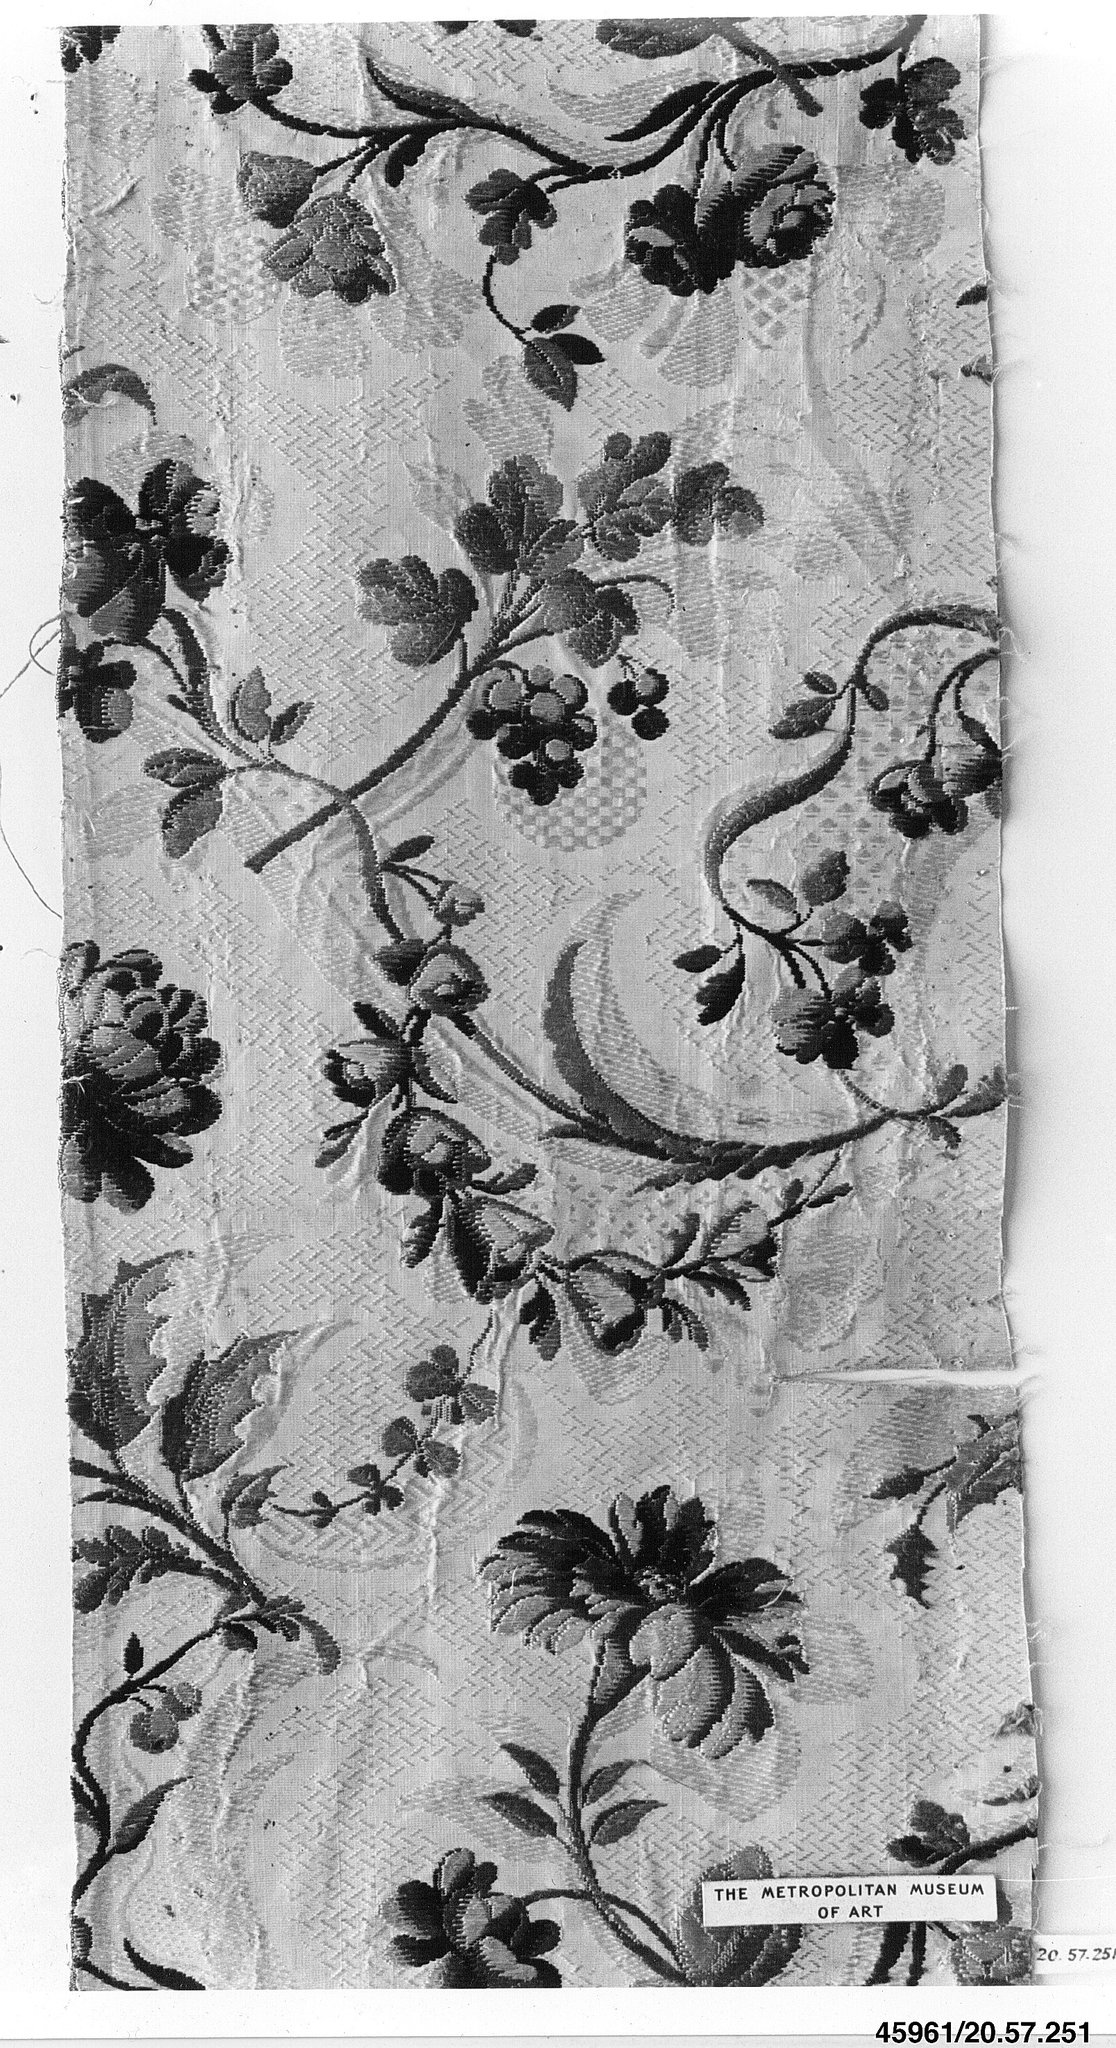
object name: piece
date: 1750-1760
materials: silk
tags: flowers,leaves